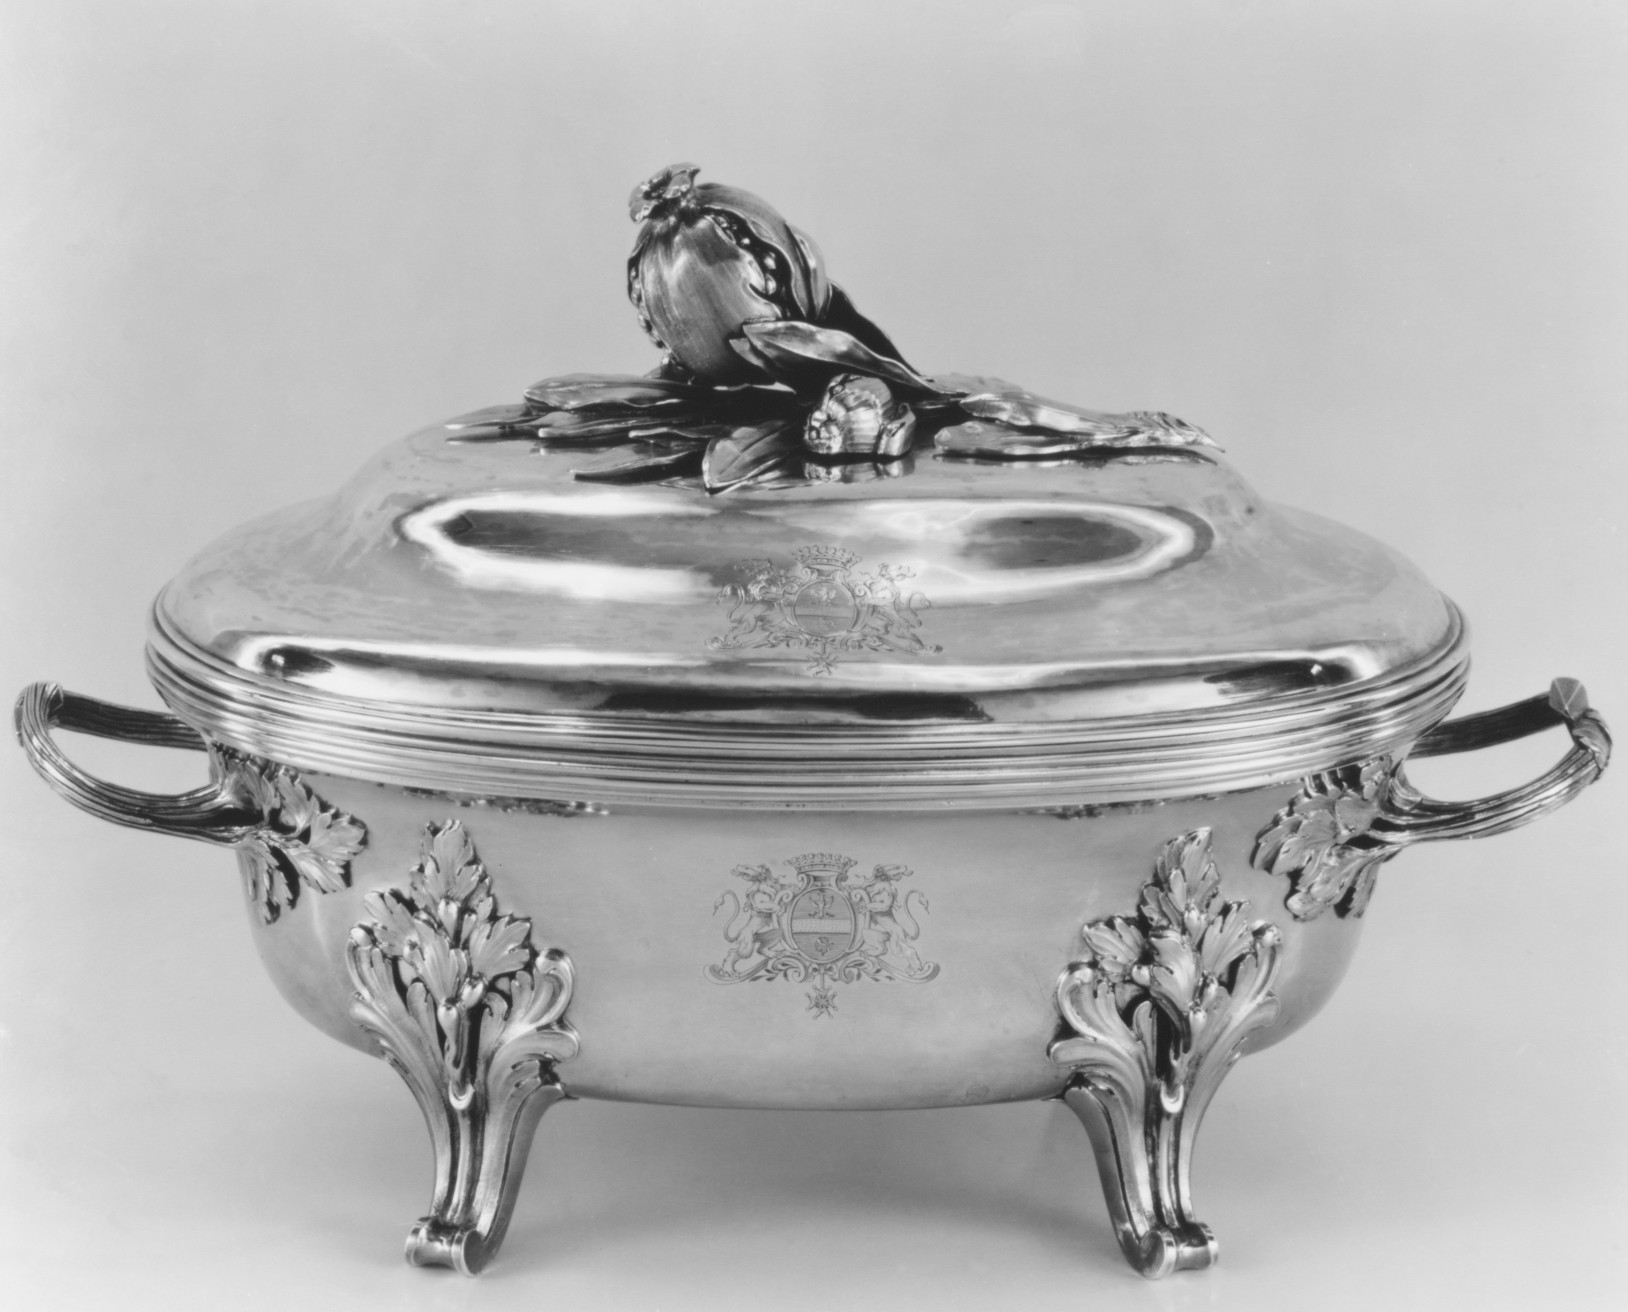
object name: tureen with cover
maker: joseph-pierre-jacques duguay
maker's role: maker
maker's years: 1724-1824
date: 1771-1772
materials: silver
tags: coat of arms